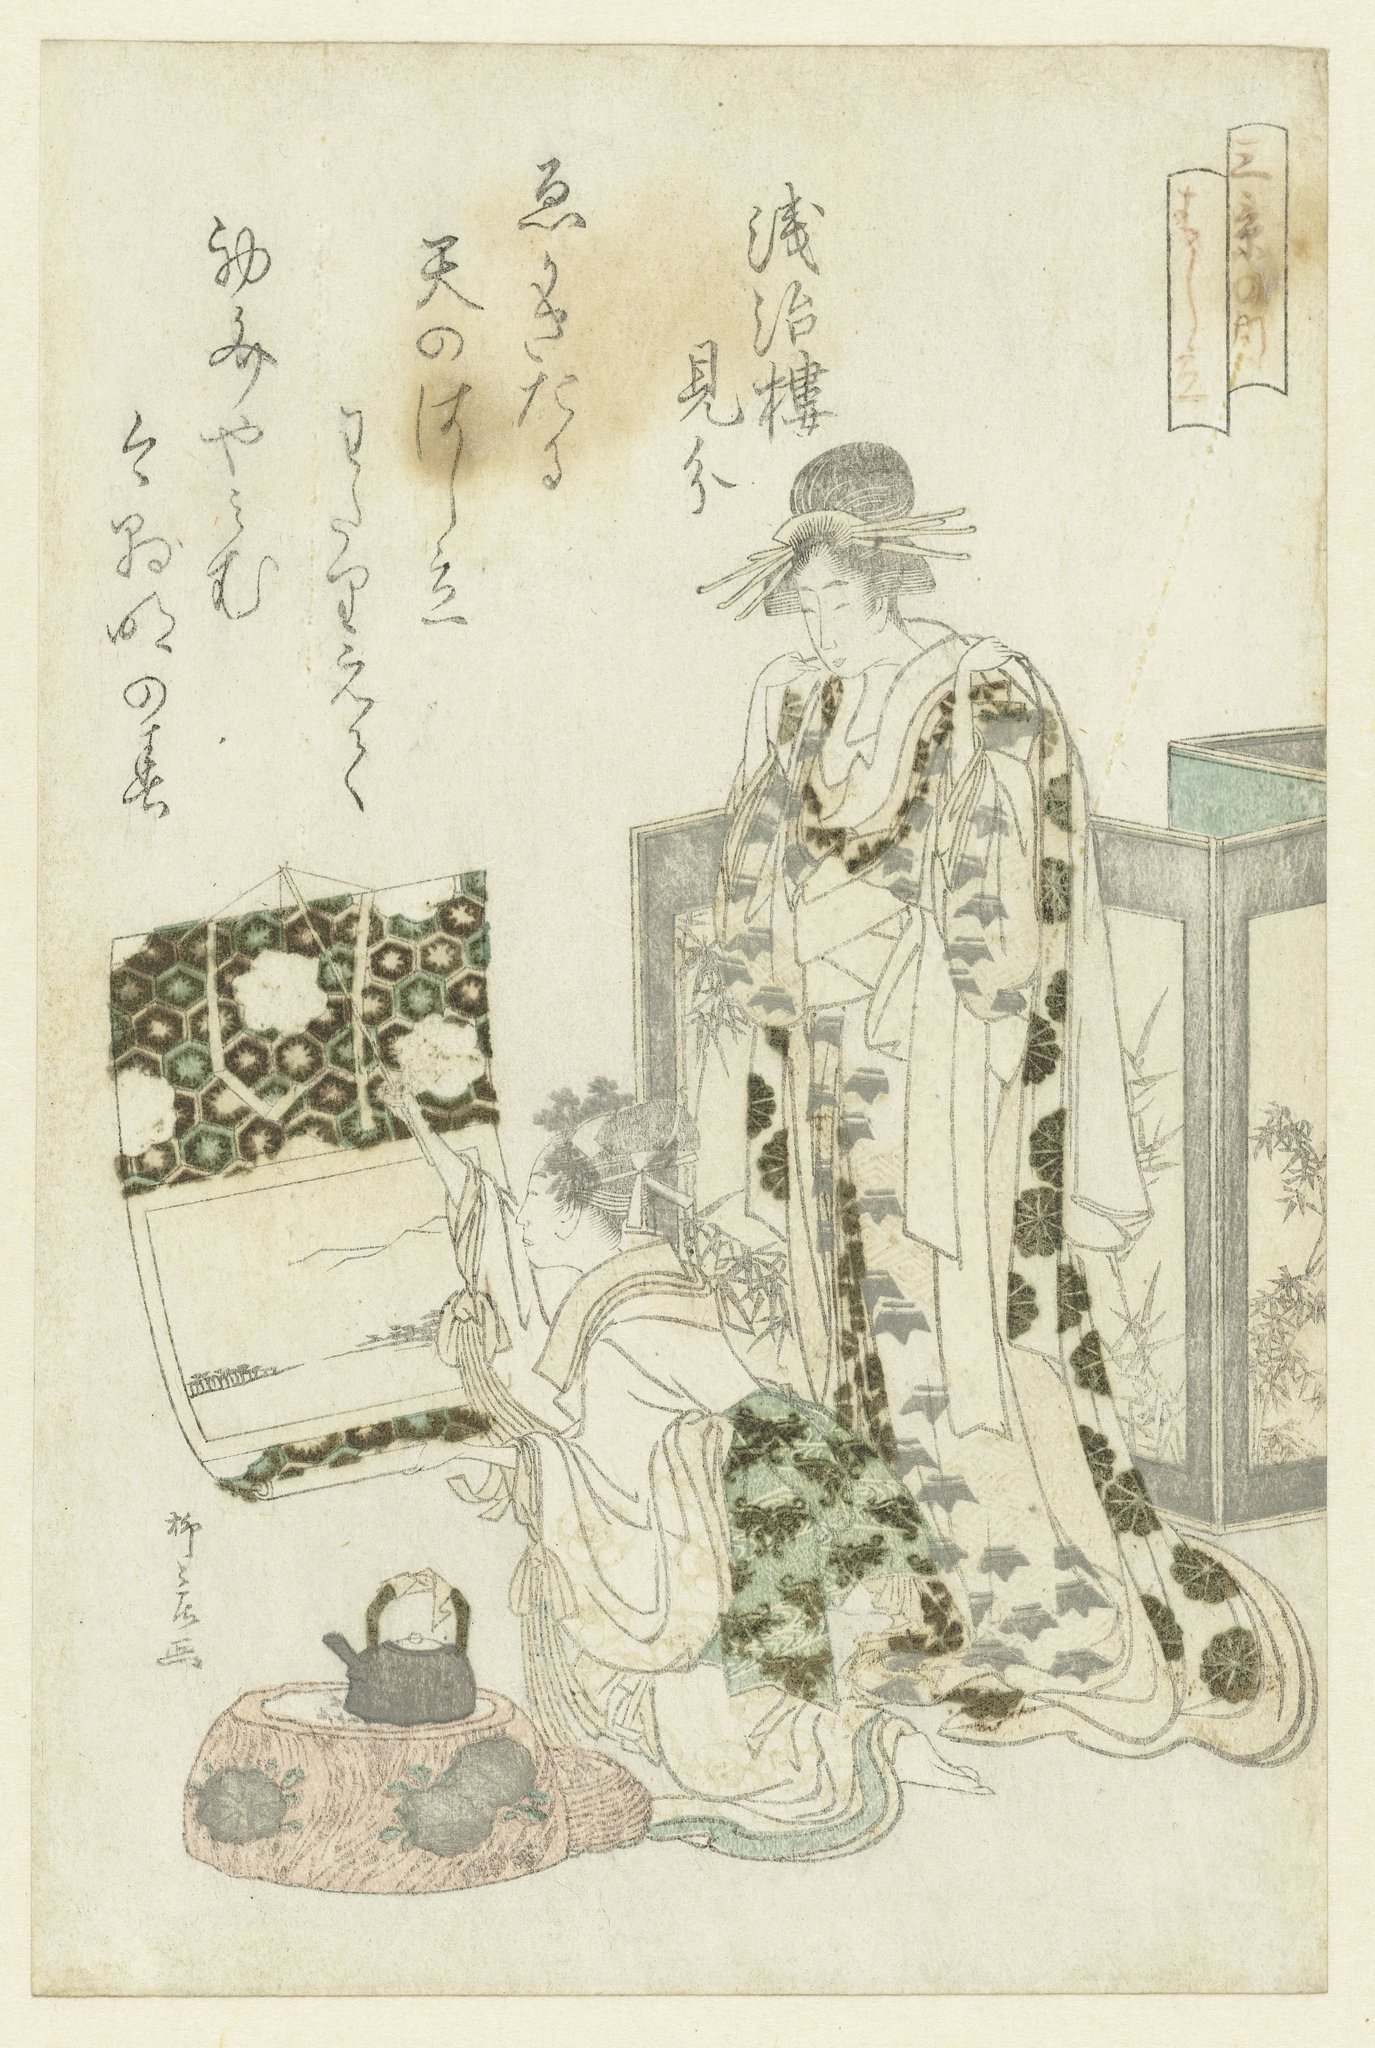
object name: print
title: Woman Hanging a Scroll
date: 1800-1805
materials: paper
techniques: woodcut, nishiki e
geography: japan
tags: courtesan, hetaera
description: Een staande courtisane kijkt toe hoe haar bediende een schildering ophangt van Amanohashidate. Deze beroemde plaats ligt in het noorden van Japan en is begroeid met pijnbomen. Met één gedicht: De 'Brug naar de hemel' in de schildering van Amanohashidate overschrijdend, de eerste droom van het nieuwe jaar kent geen einde.